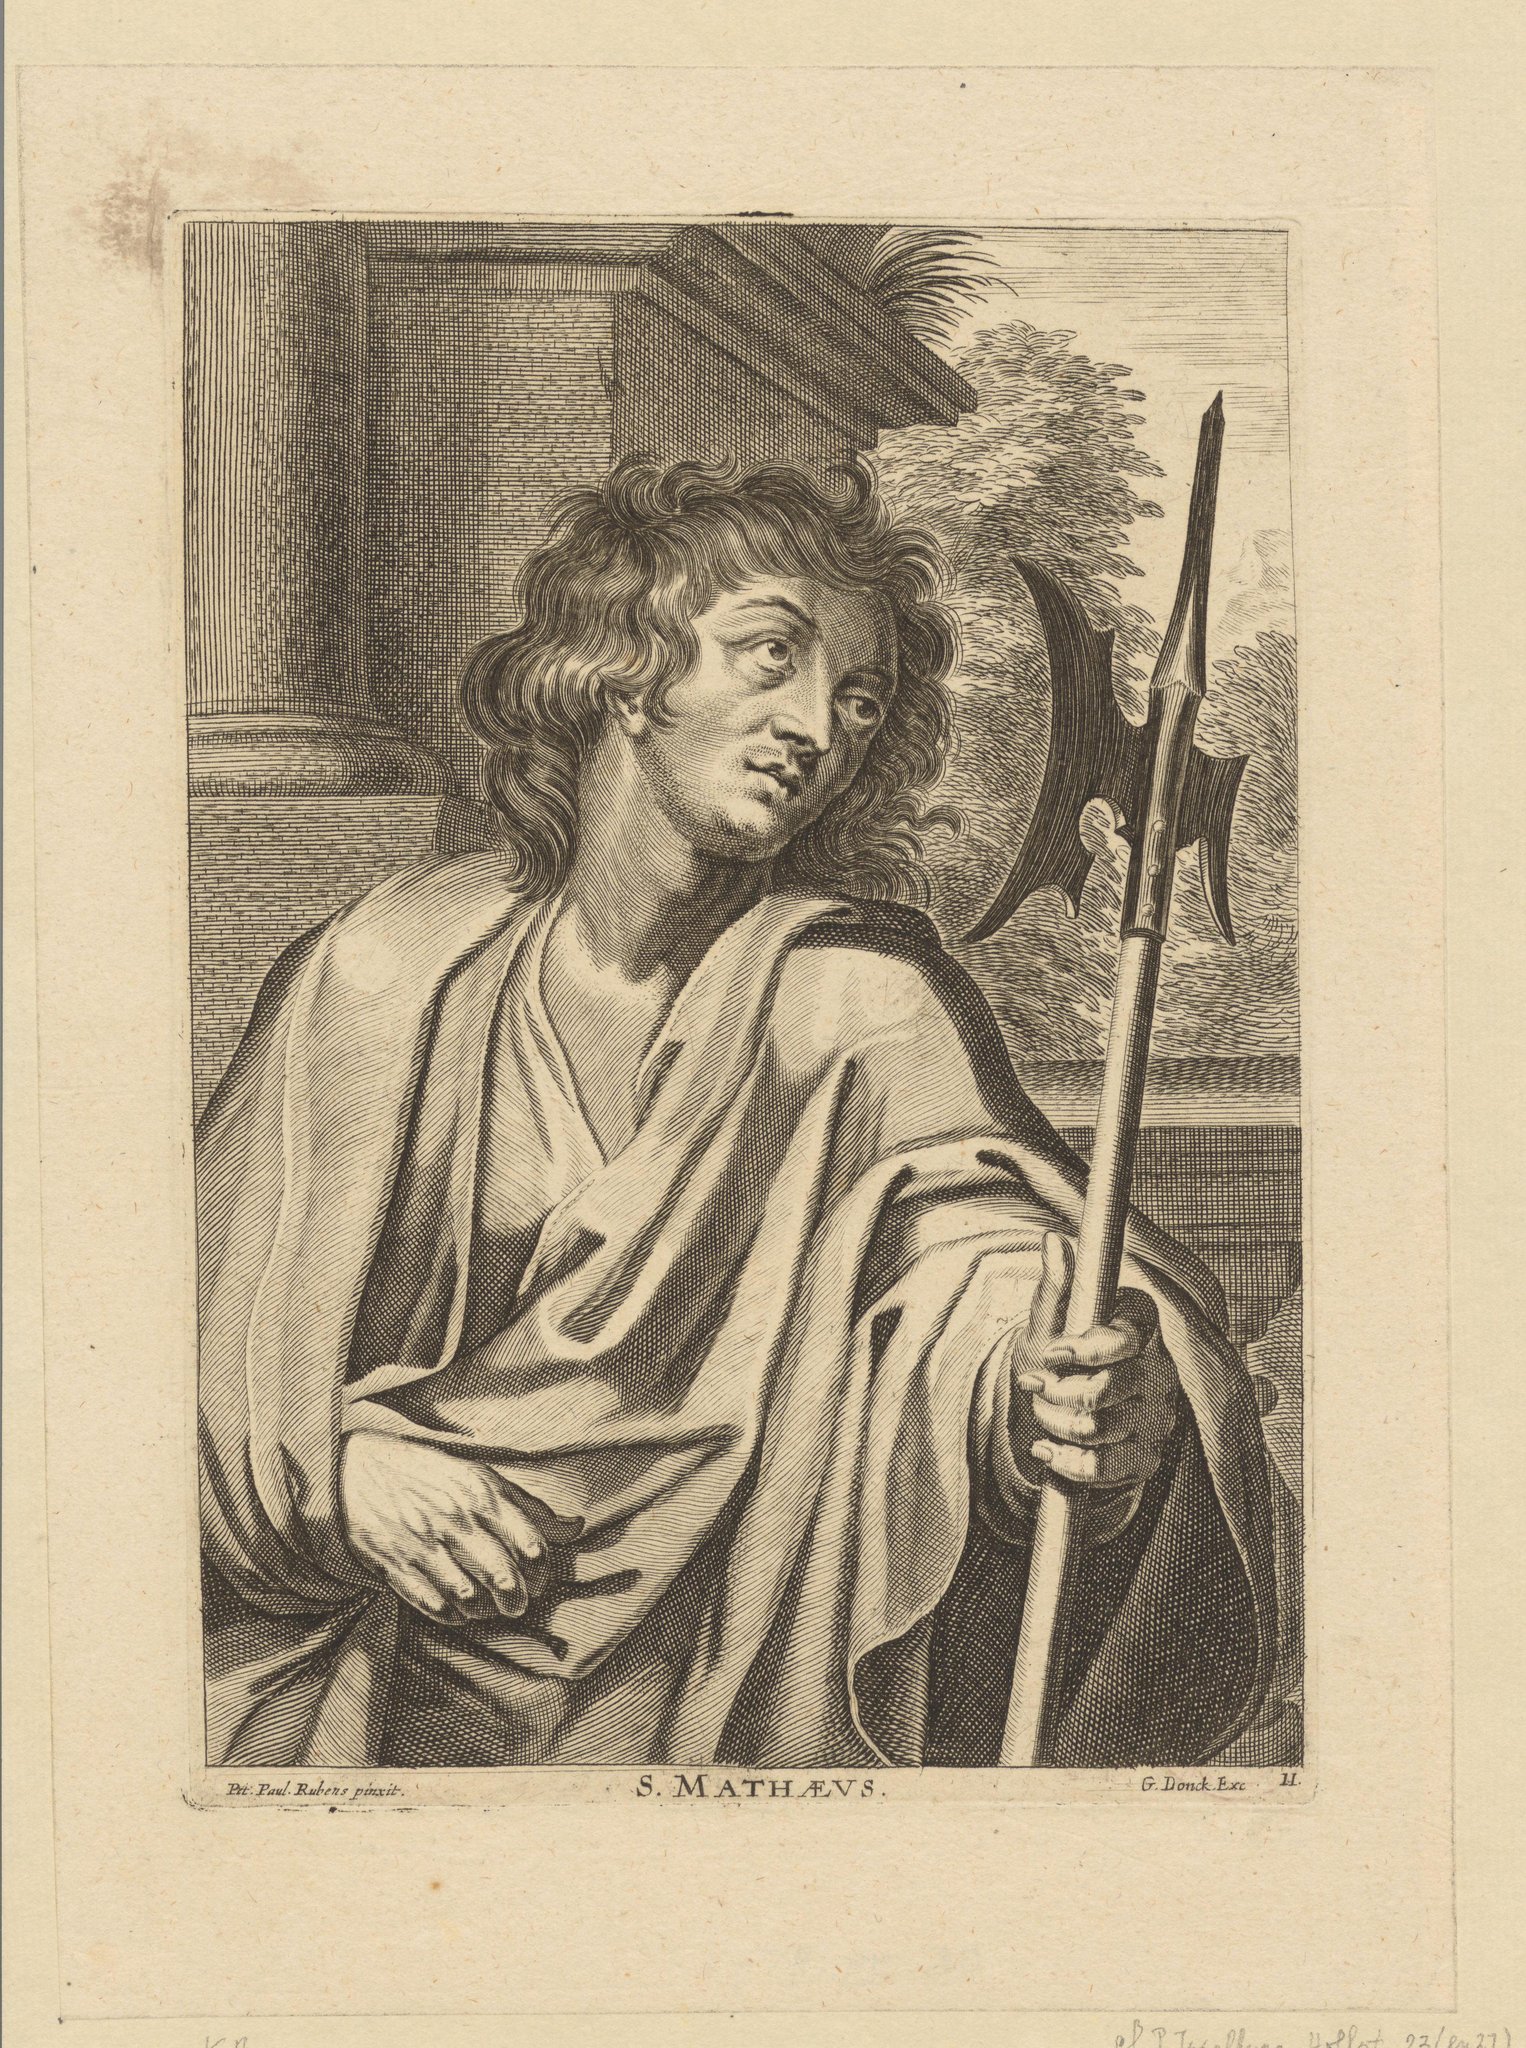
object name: print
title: H. Matteüs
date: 1611-1612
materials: paper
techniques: engraving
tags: the apostle and evangelist matthew (mattheus); possible attributes: angel, axe, book, halberd, pen and inkhorn, purse, scroll, square, sword